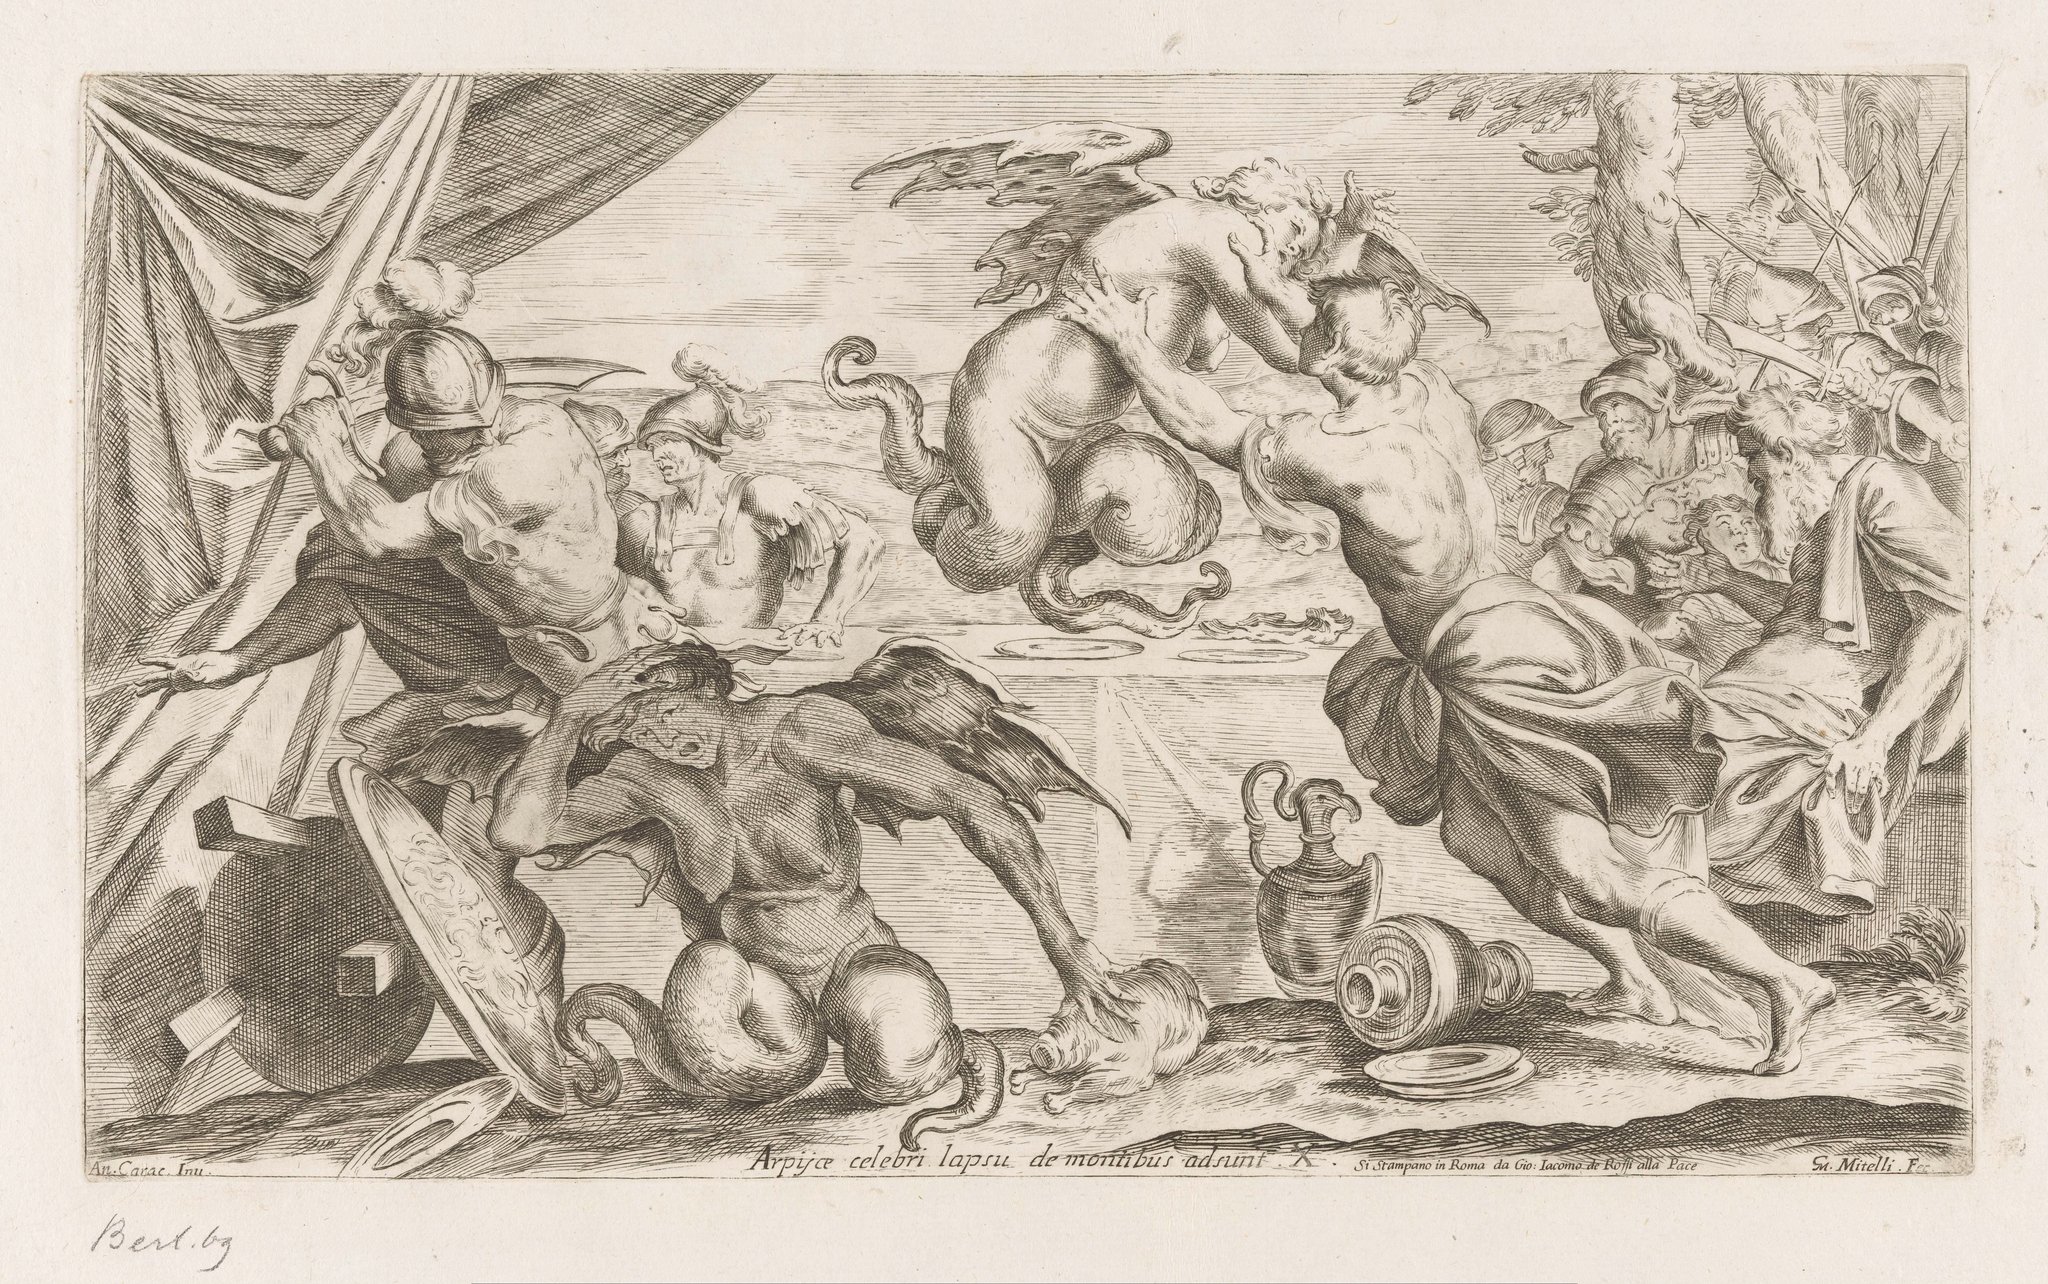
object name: print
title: Arpijae celebri lapsu de montibus adsunt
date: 1663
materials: paper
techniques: etching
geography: italy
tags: stay of aeneas on the strophades islands: fight with the harpies that befoul the crew's food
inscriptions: collector's mark: Lugt 2228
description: Aeneas en zijn metgezellen worden gestoord tijdens een maaltijd door Harpijen. Er ontstaat een gevecht tussen de soldaten en de Harpijen. Genummerd: X.